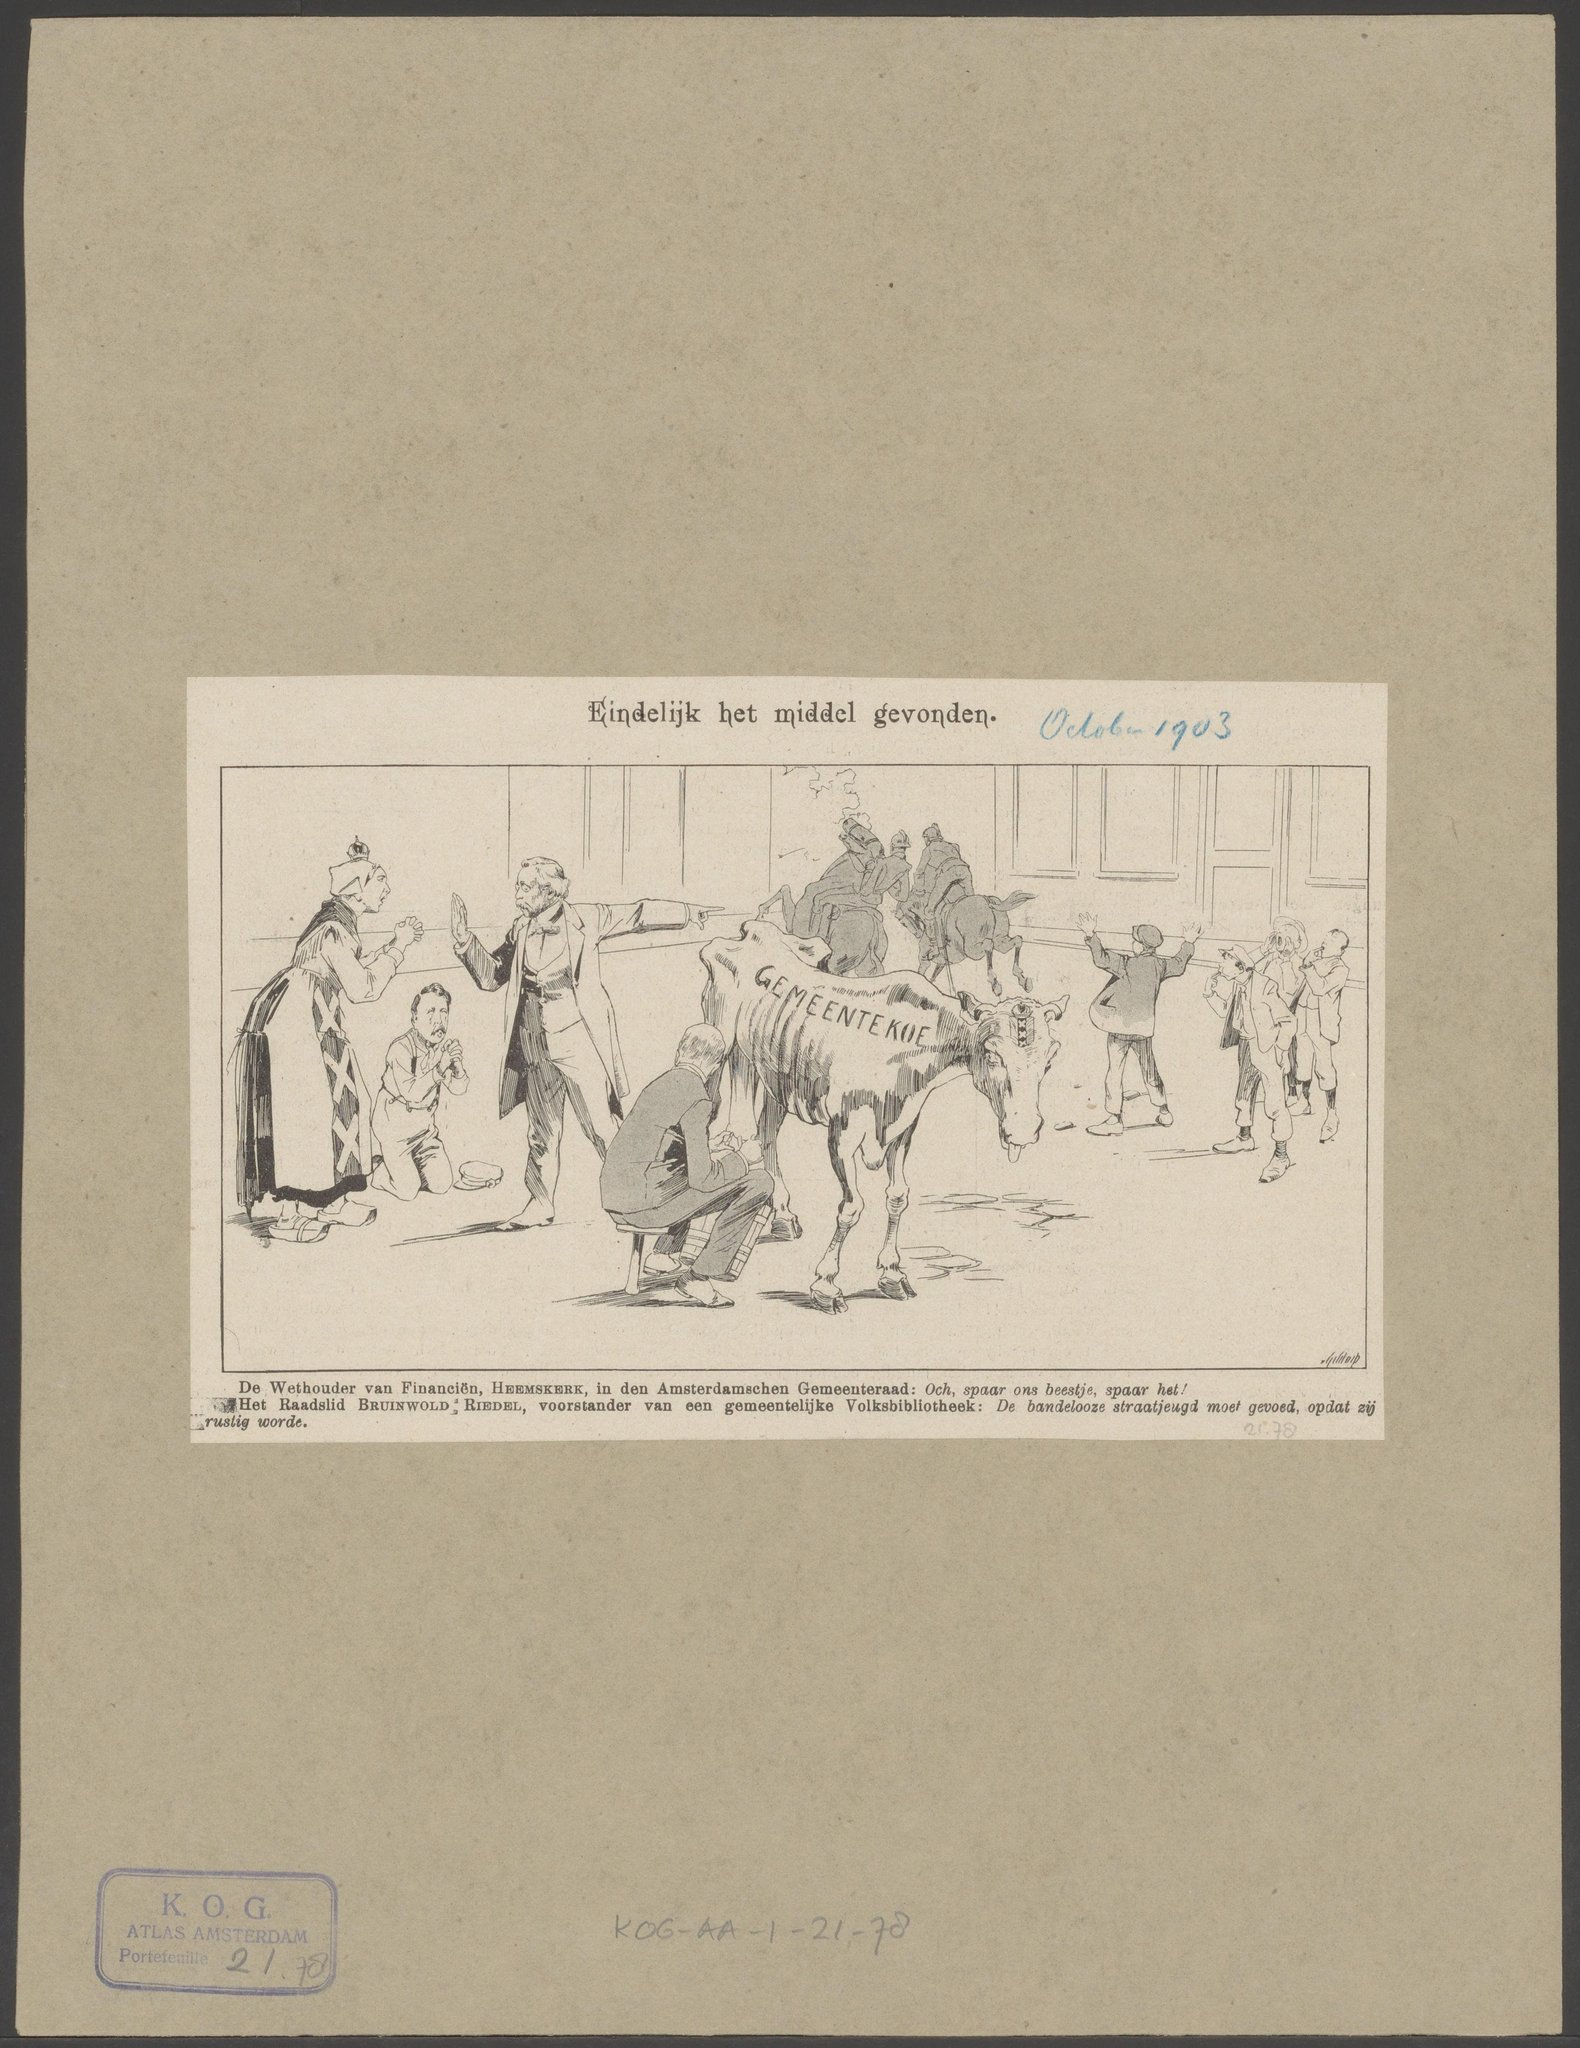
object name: photomechanical print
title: Eindelijk het middel gevonden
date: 1903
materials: paper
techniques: letterpress printing, line block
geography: netherlands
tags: the hague, amsterdam, utrecht, cow, youth culture, politician, e.g. party leader, milking, political caricatures and satires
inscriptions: inscription: ‘October 1903’, collector's mark: Lugt 1641b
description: Prent uit: Geïllustreerd zondagsblad voor katholieken, 18 oktober 1903, p. 124.